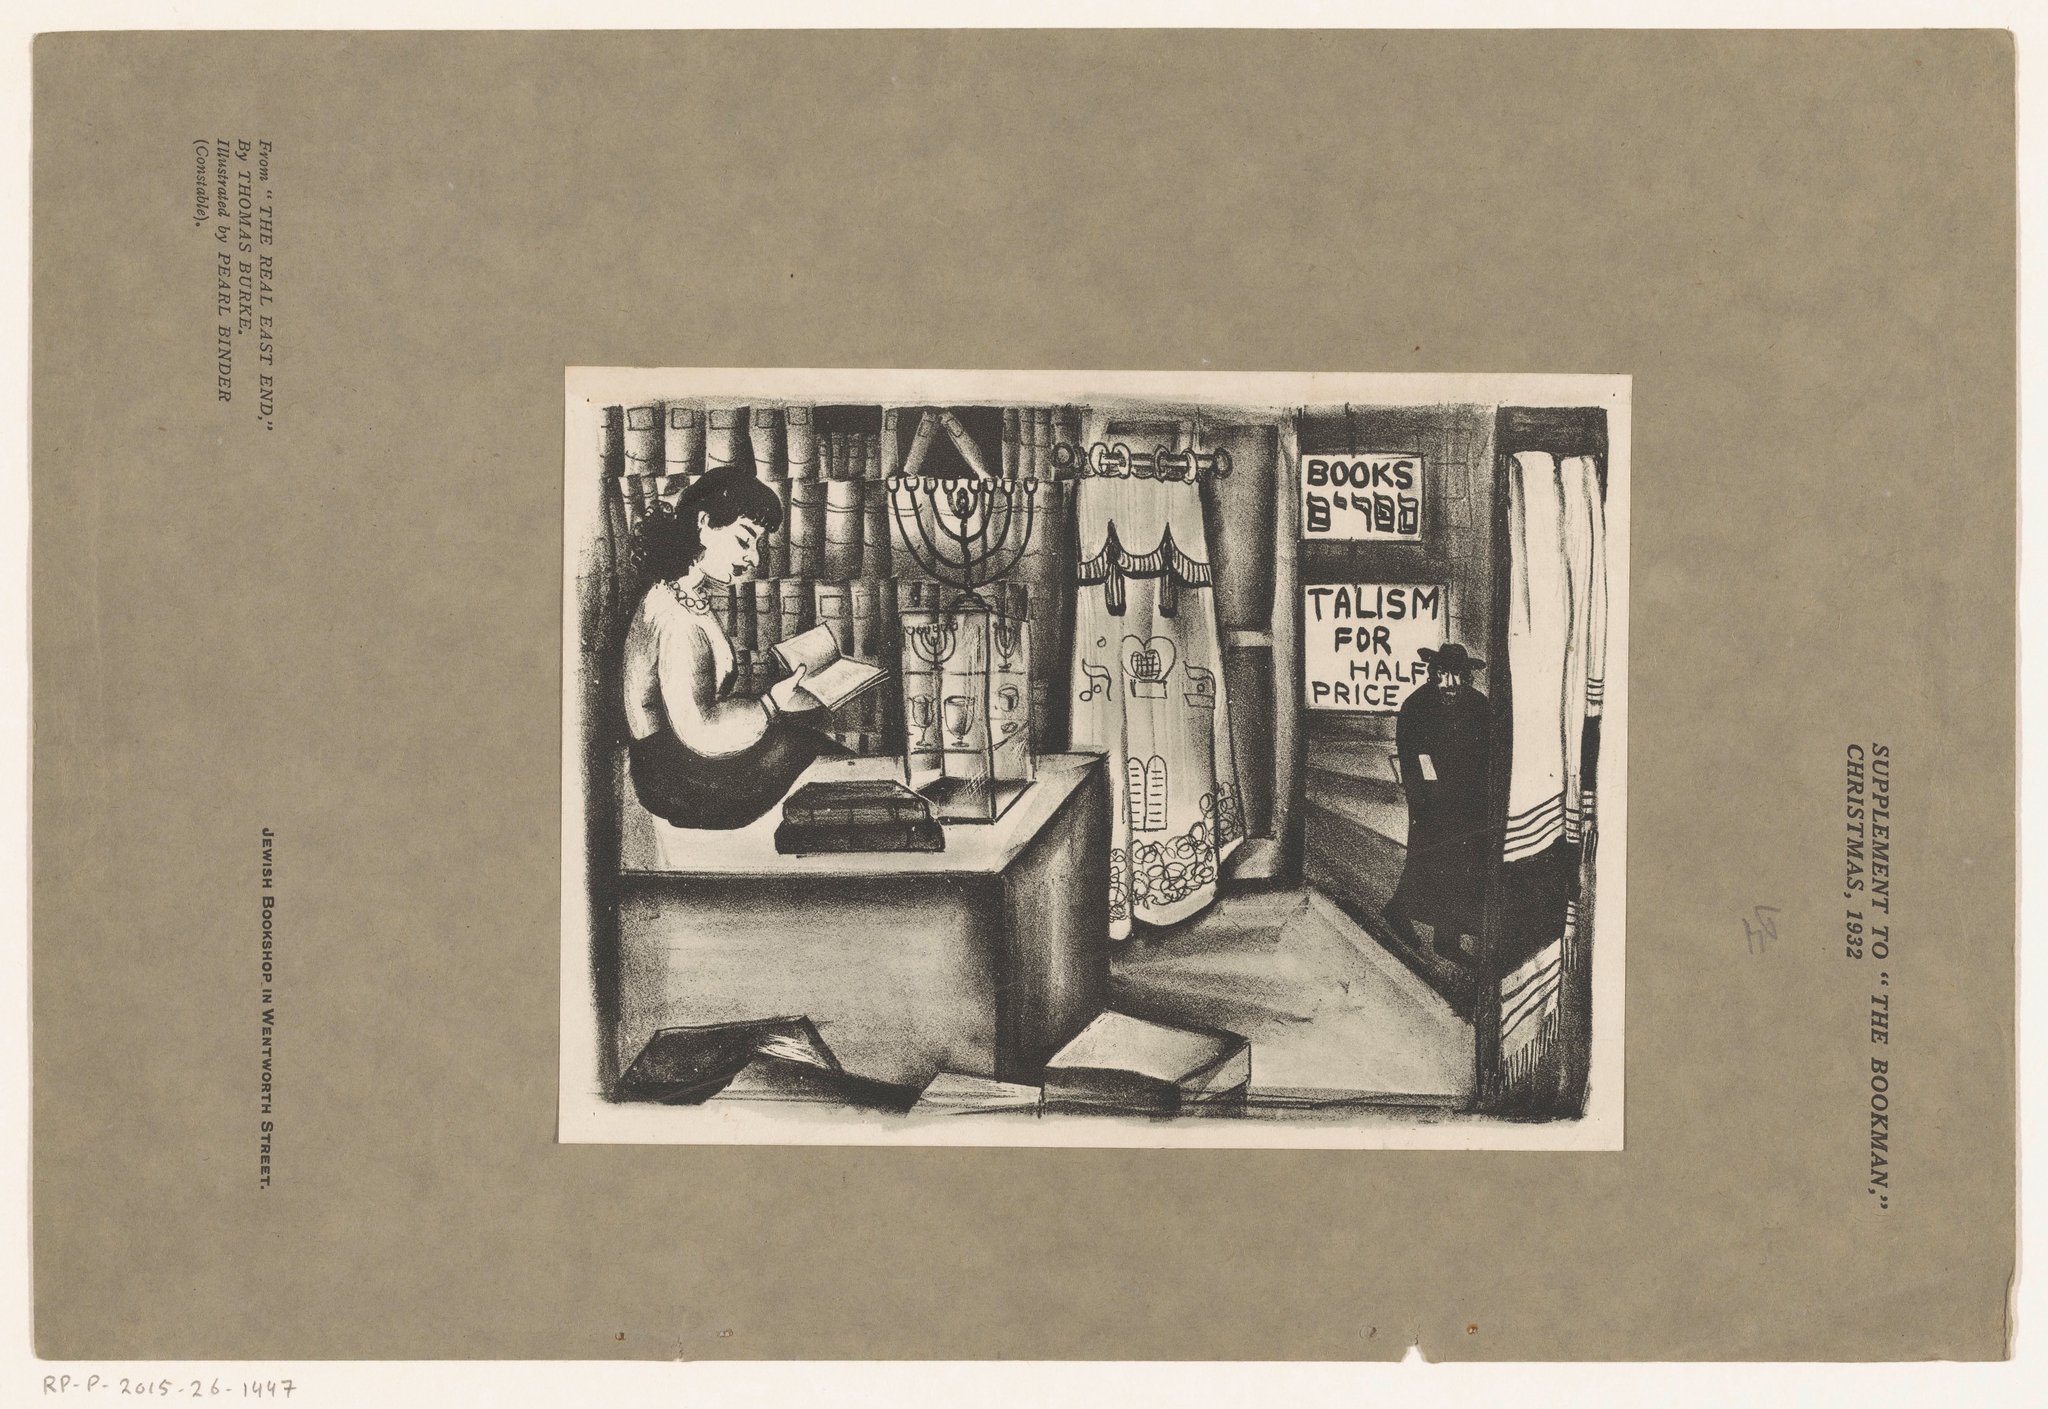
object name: print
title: Jewish Bookshop in Wentworth Street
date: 1932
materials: paper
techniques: printing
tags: reading, book-shop, bookseller, jewish religion and culture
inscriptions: collector's mark: Lugt 4780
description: Op de toonbank naast een vitrine met een chanoekalamp en andere religieuze objecten zit een vrouw te lezen. Naast de deur hangen gebedskleden. Op straat loopt een joodse man met een boek onder zijn arm.